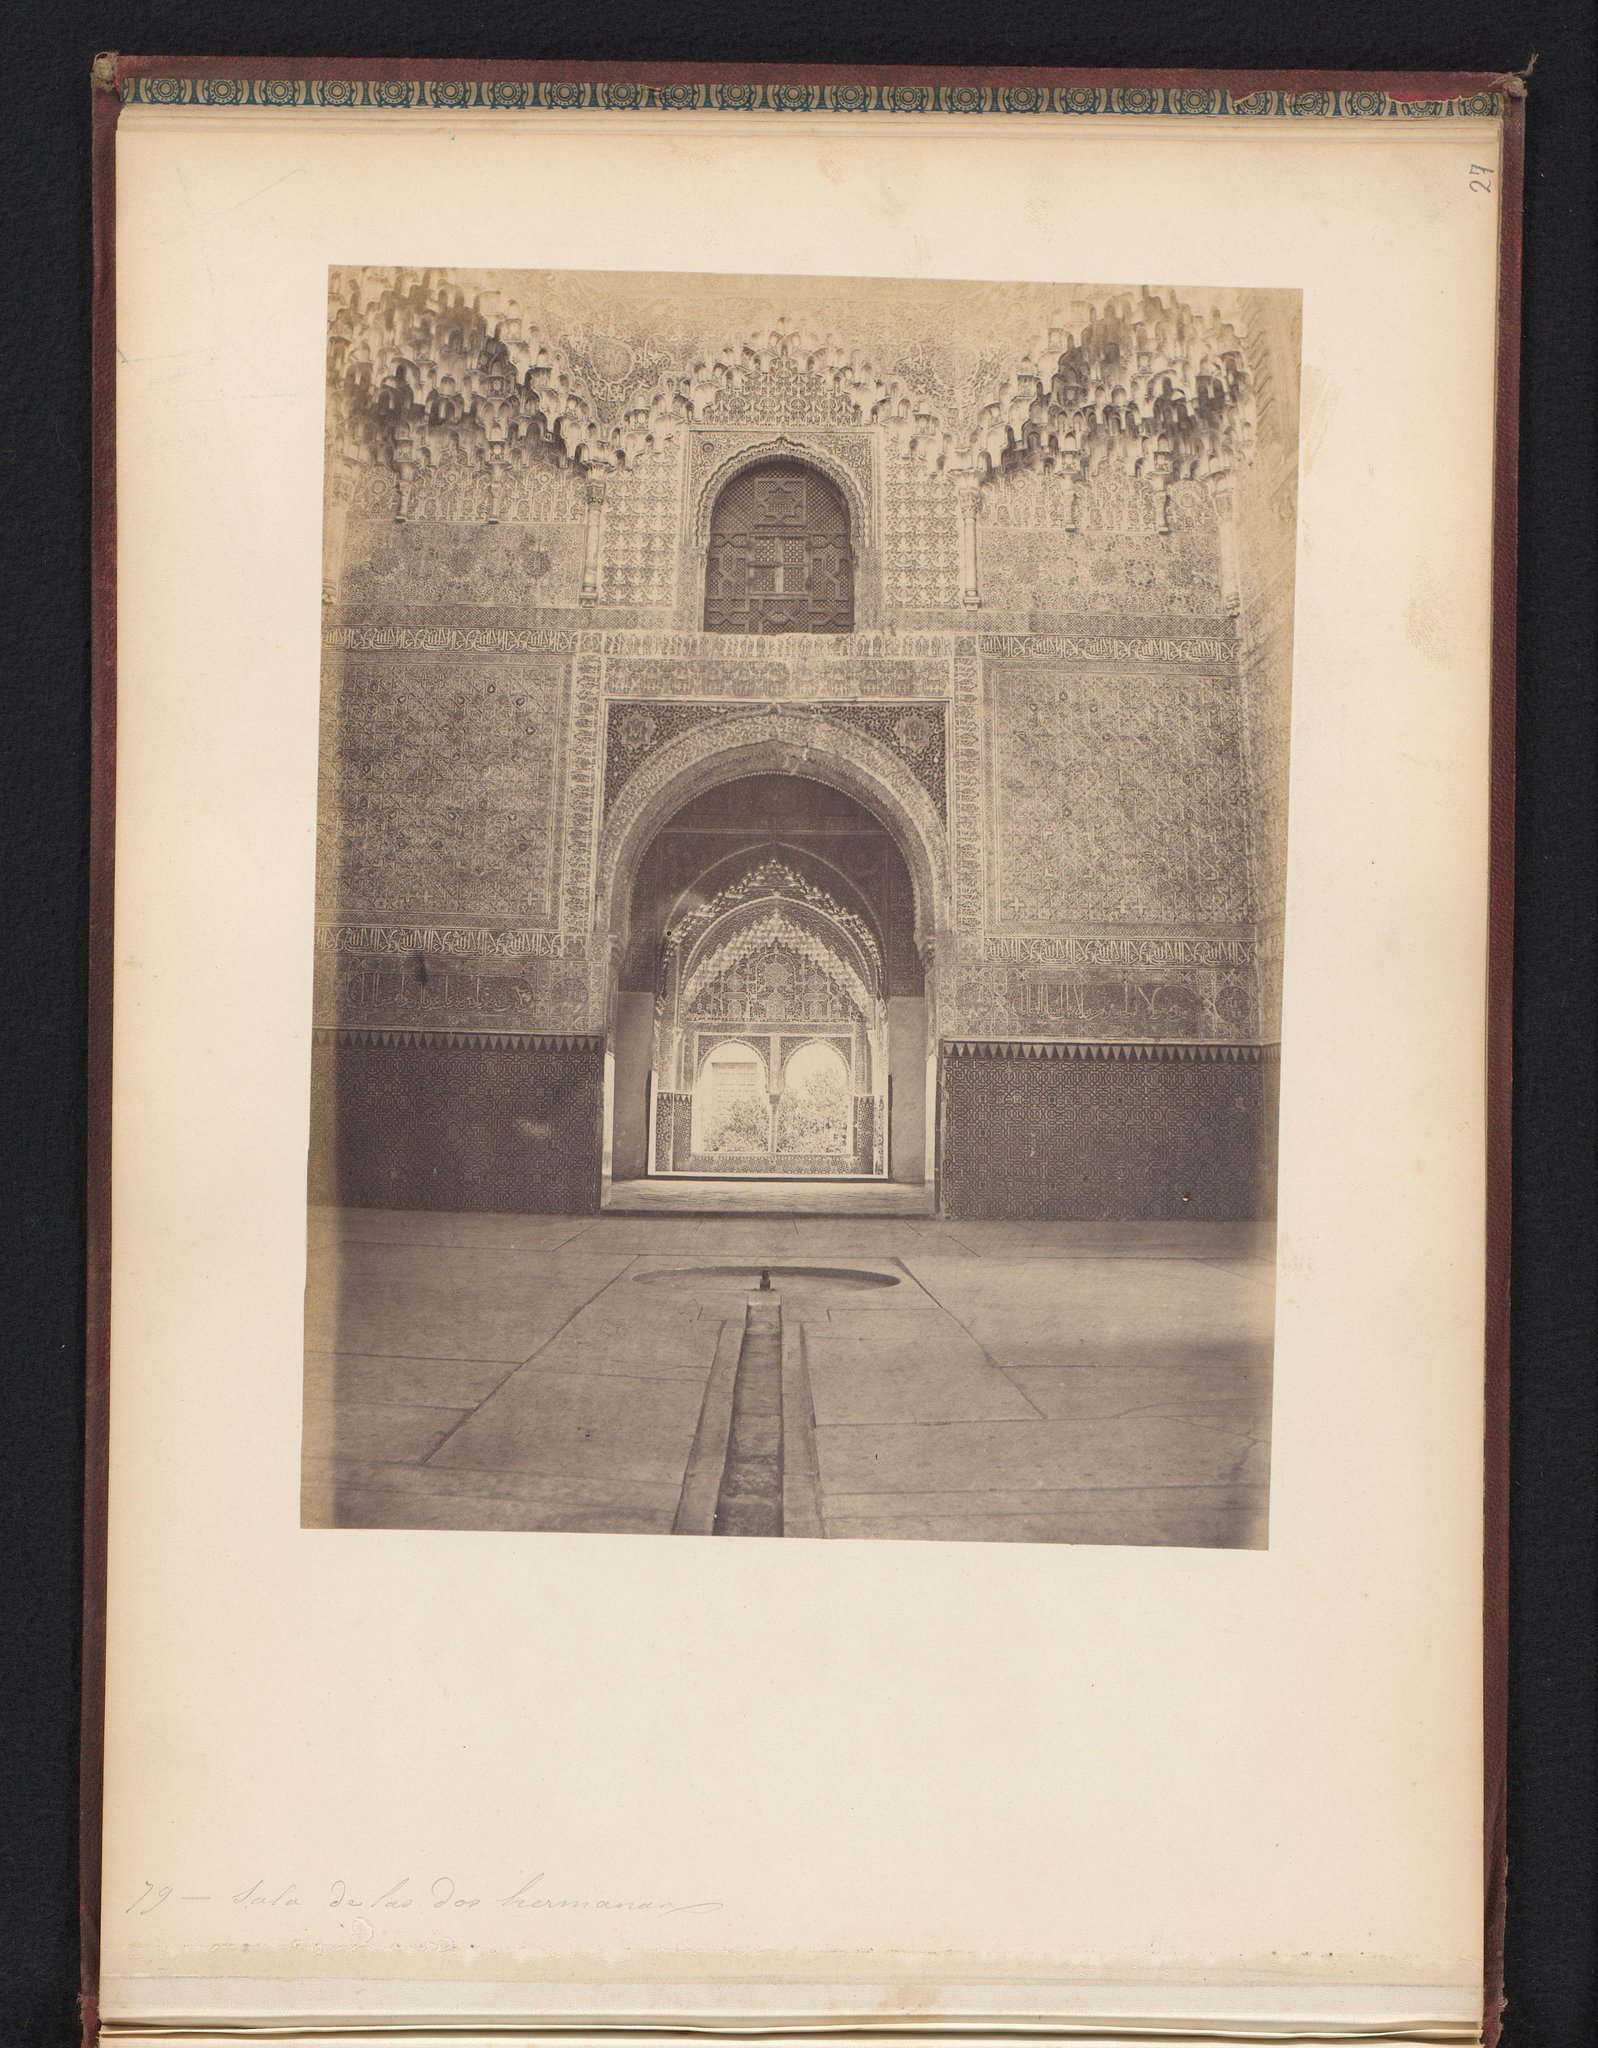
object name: photograph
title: Interieur van de Sala de Dos Hermanas in het Alhambra te Granada, Spanje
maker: c maufsaise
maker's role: fotograaf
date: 1906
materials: paper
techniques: albumen print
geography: granada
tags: palace, interior ~ representation of a building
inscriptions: number: ‘79’